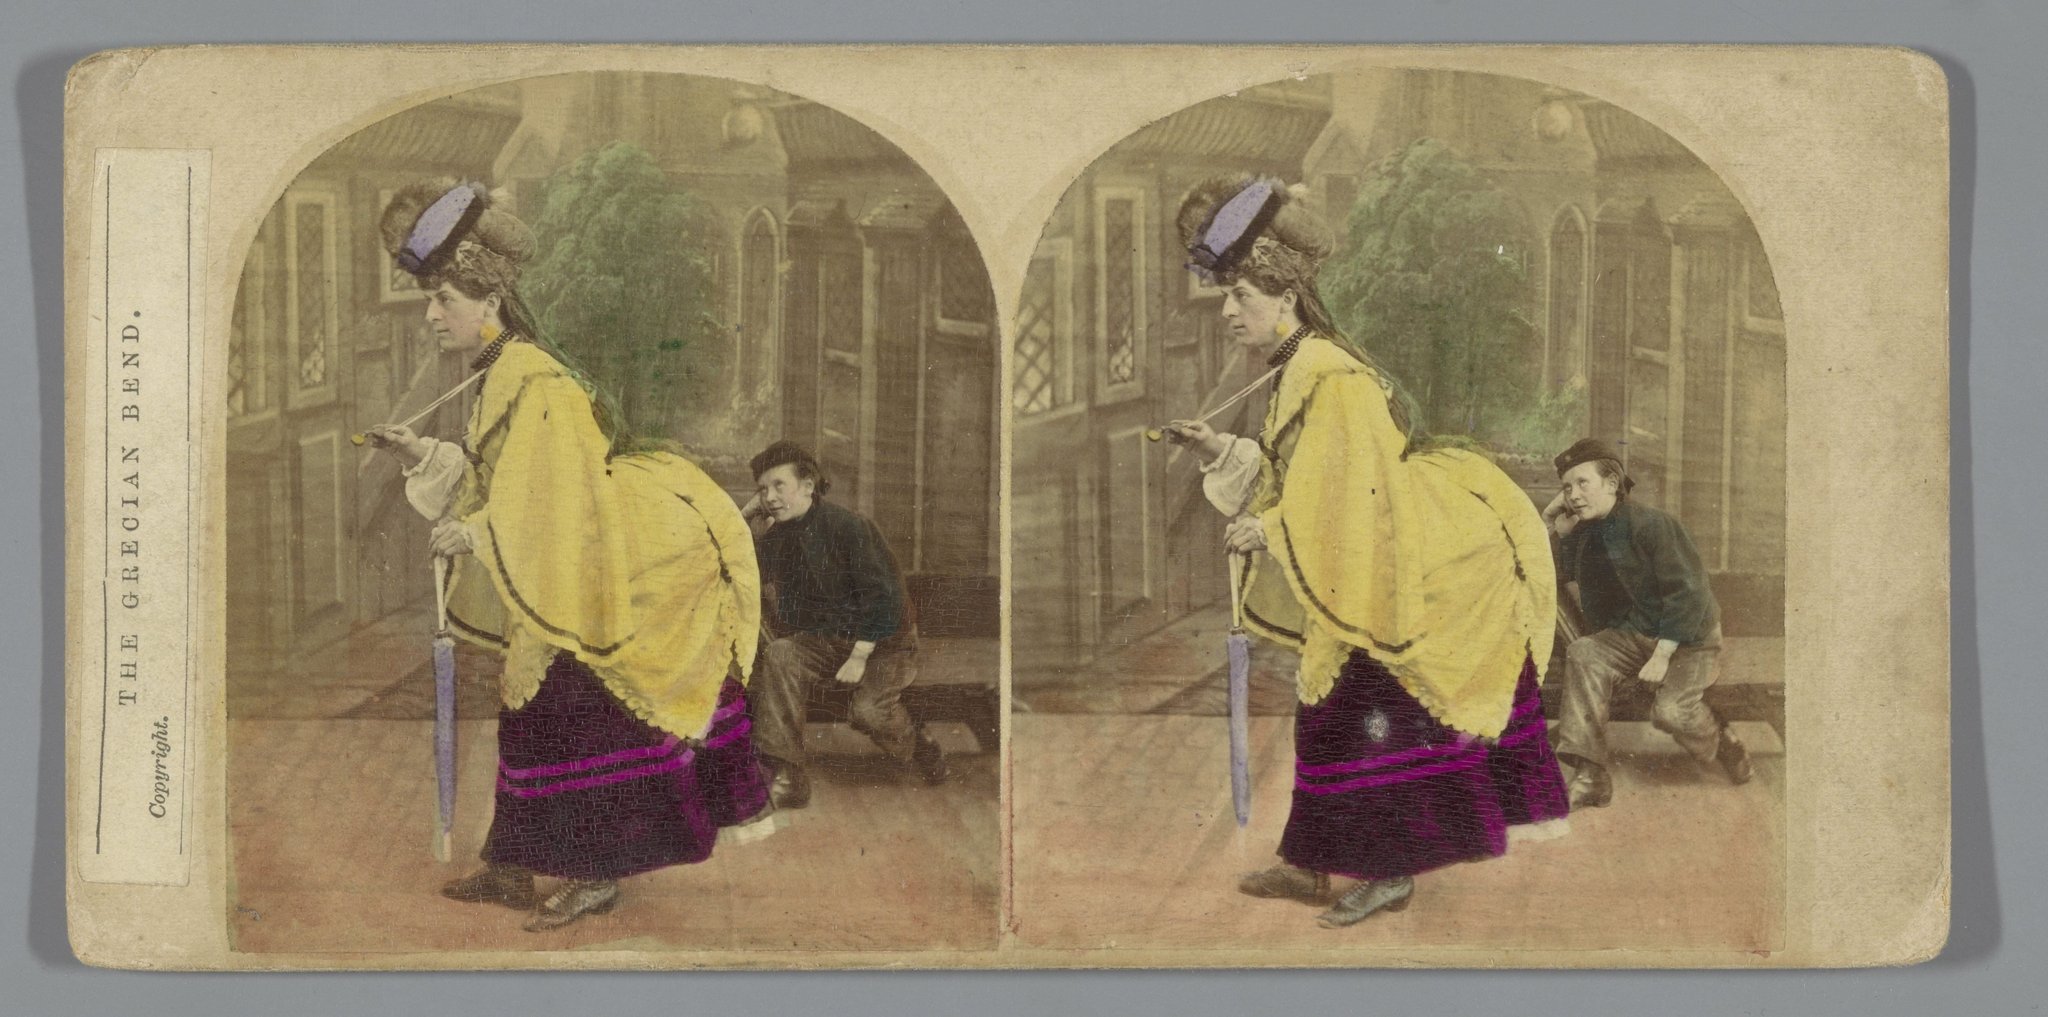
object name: stereograph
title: Vrouw in een tournure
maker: Anonymous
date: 1852-1863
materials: cardboard, paper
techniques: albumen print, hand coloring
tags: adult woman, bending figure, skirt (crinoline skirt) (+ women's clothes)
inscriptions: copyright notice: ‘THE GRECIAN BEND./ copyright’